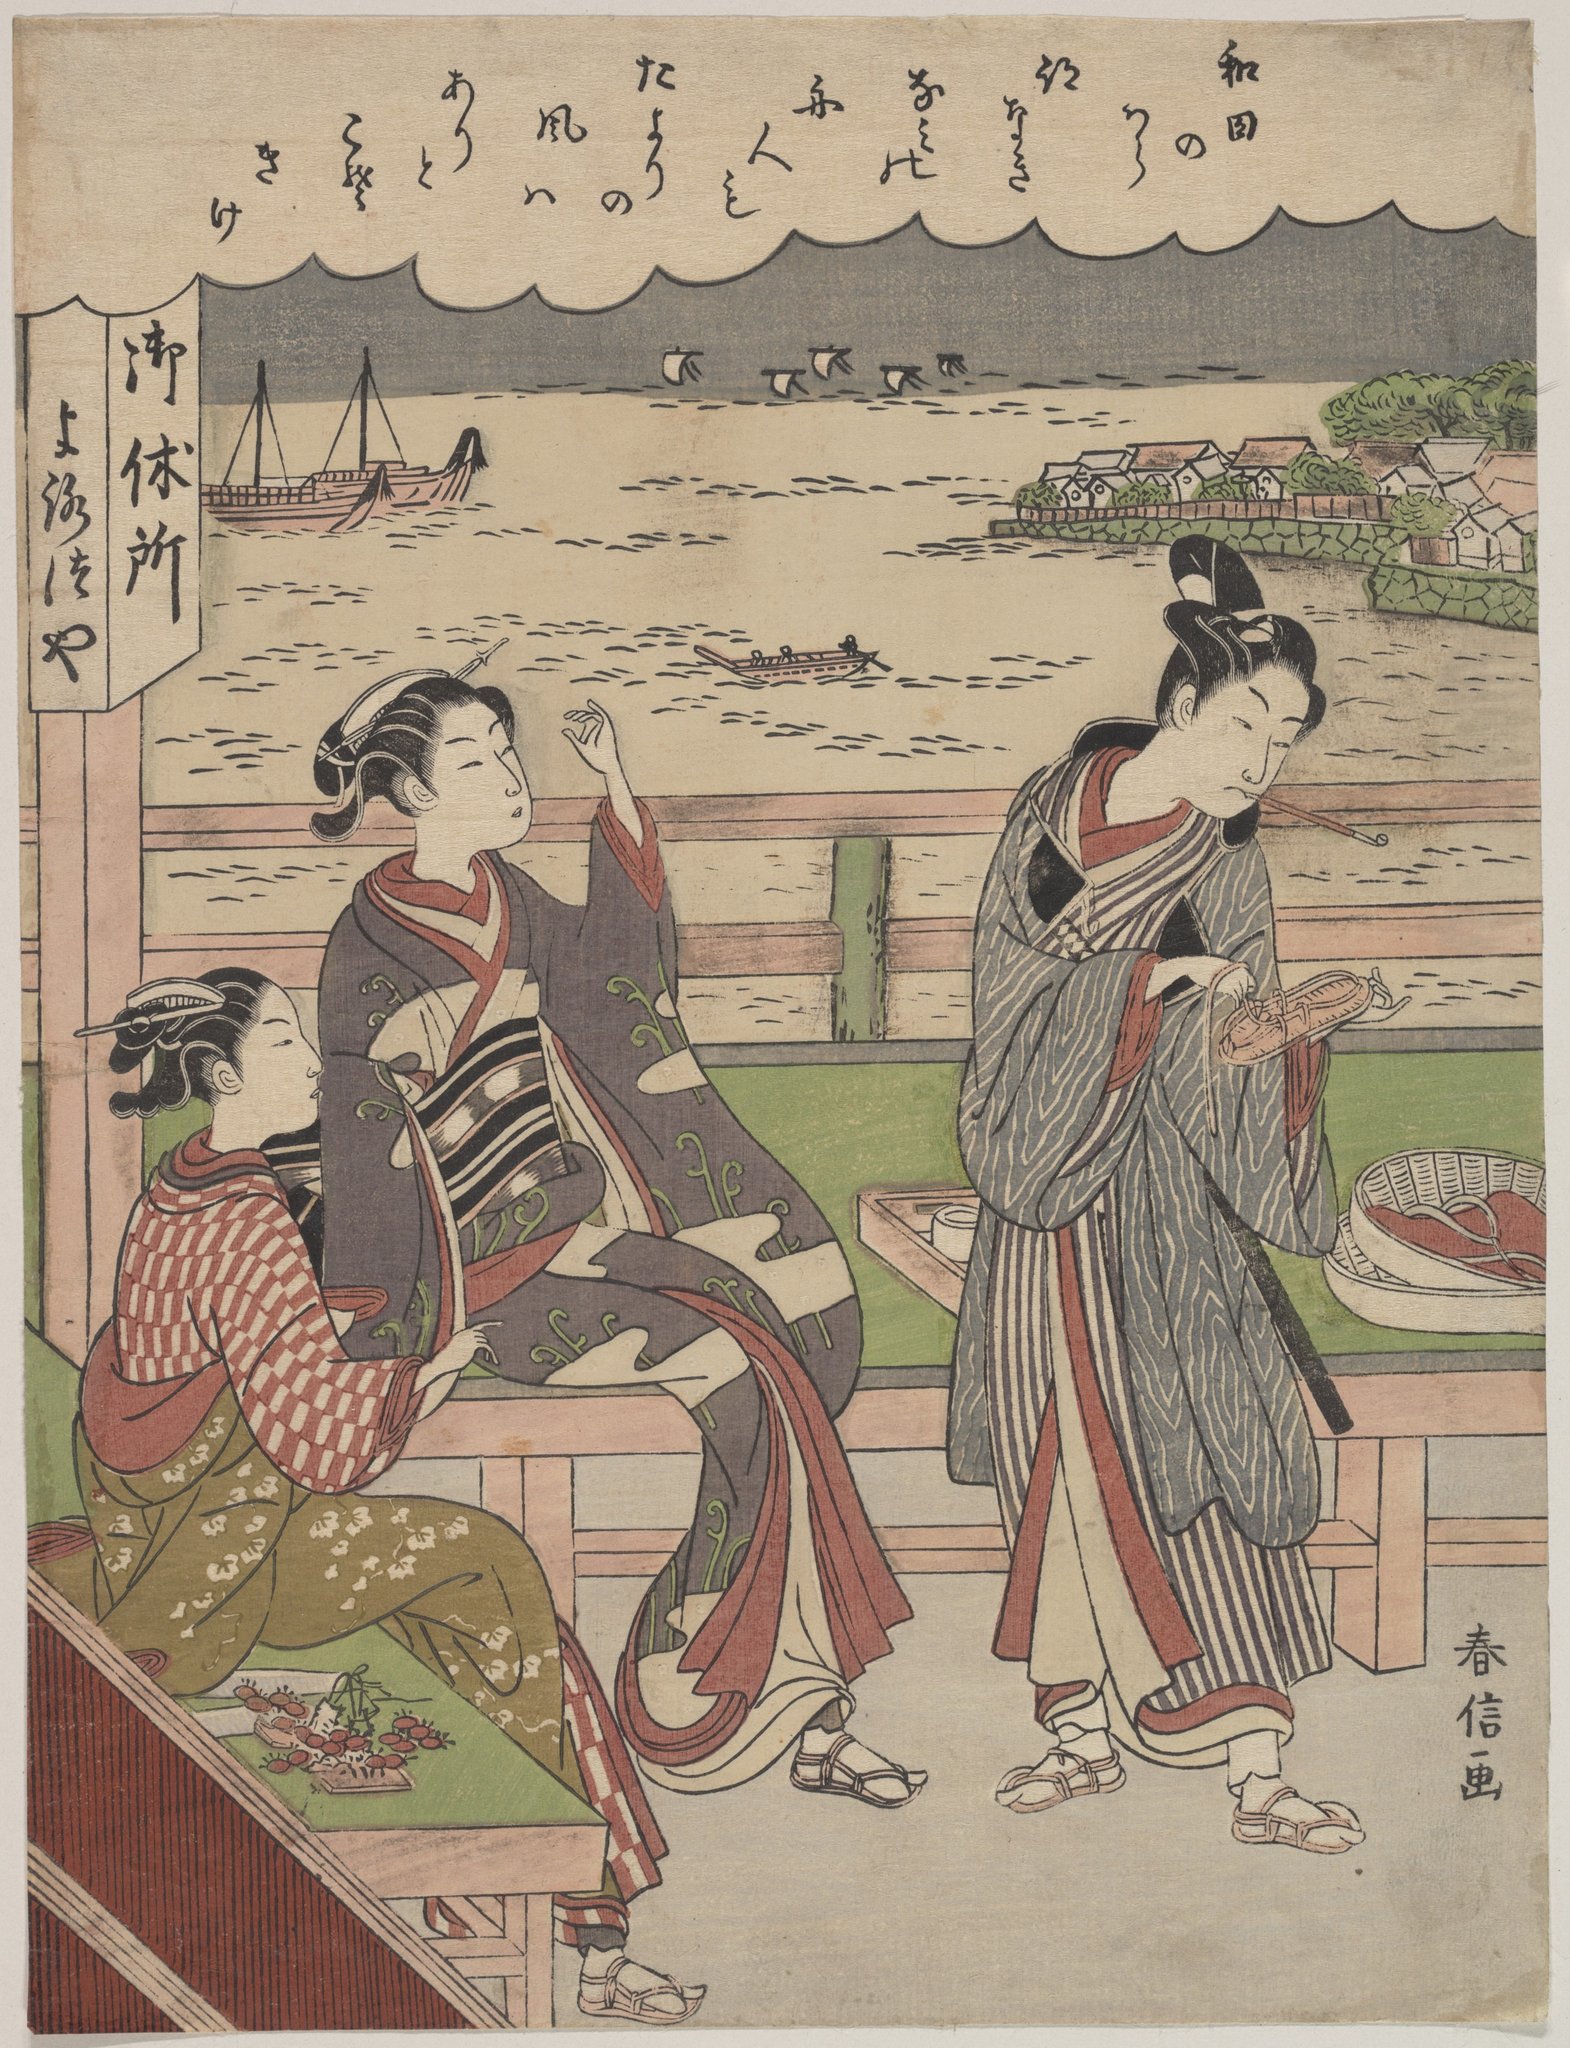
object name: print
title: A Man and Two Women at a Teahouse at Wada no Ura Overlooking the Sea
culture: japanese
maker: suzuki harunobu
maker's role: artist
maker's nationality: japanese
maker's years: 1725-1770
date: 1725-1770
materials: ink, paper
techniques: woodblock print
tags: men,women,tea houses